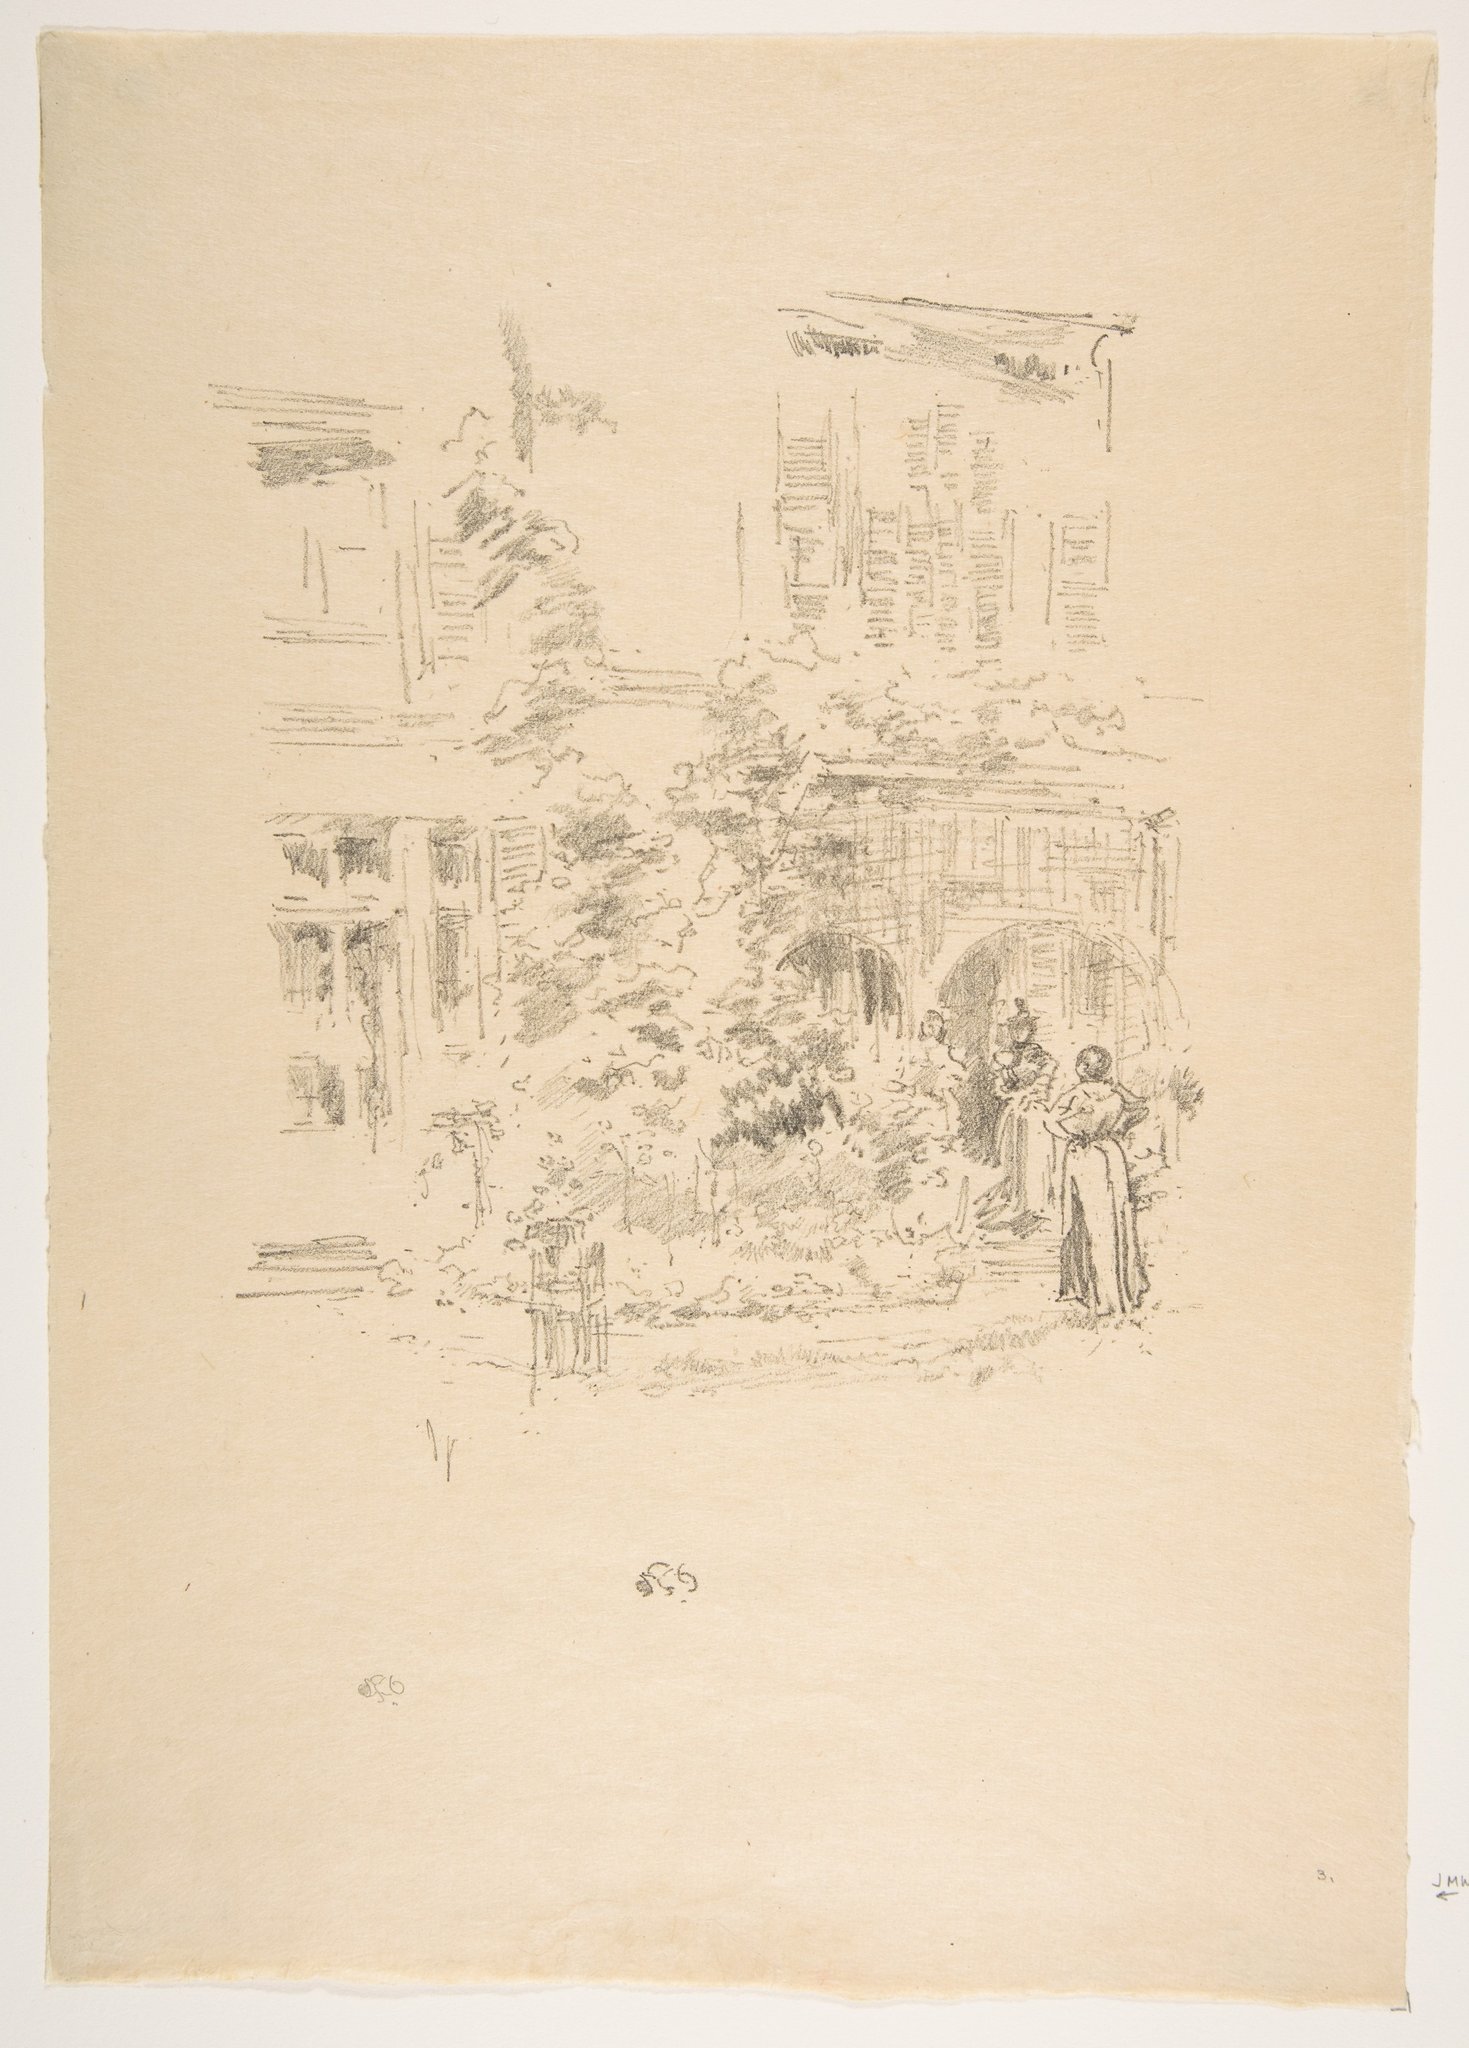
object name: print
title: The Garden Porch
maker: james mcneill whistler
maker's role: artist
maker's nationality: american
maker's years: 1834-1903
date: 1894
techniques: printing, lithography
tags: human figures,buildings,gardens